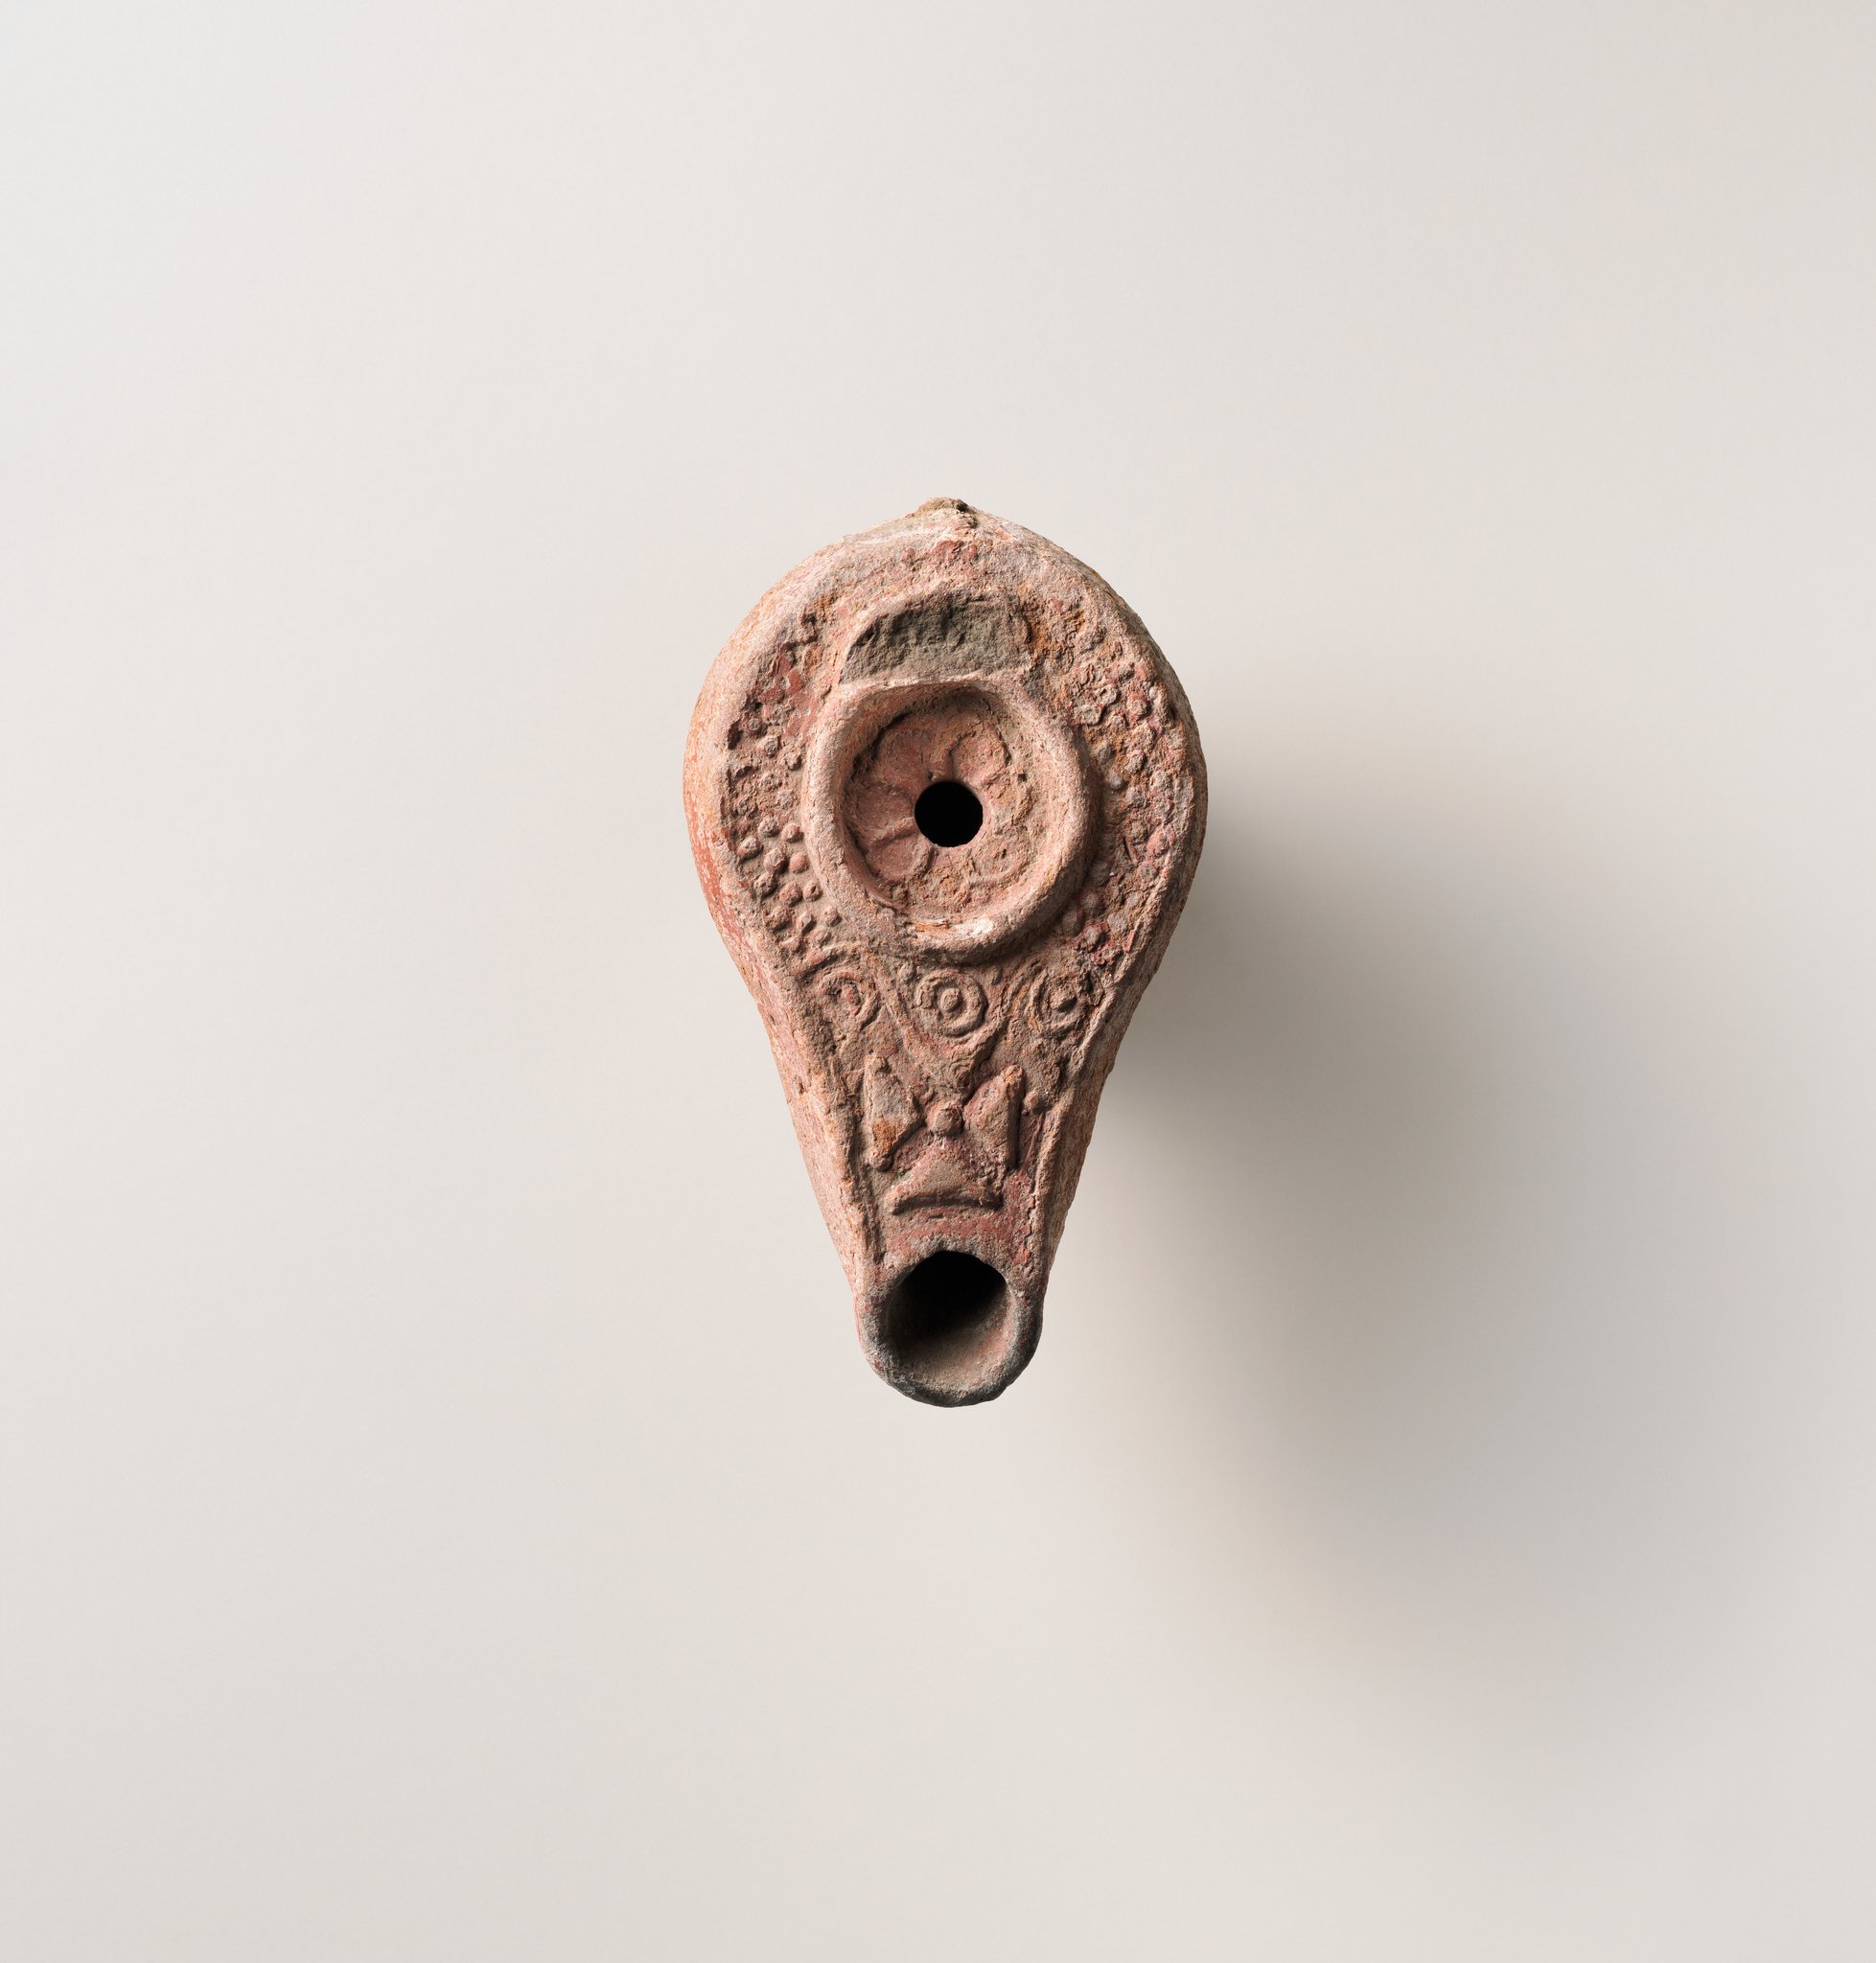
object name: lamp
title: Terracotta oil lamp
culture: roman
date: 201-300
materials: terracotta